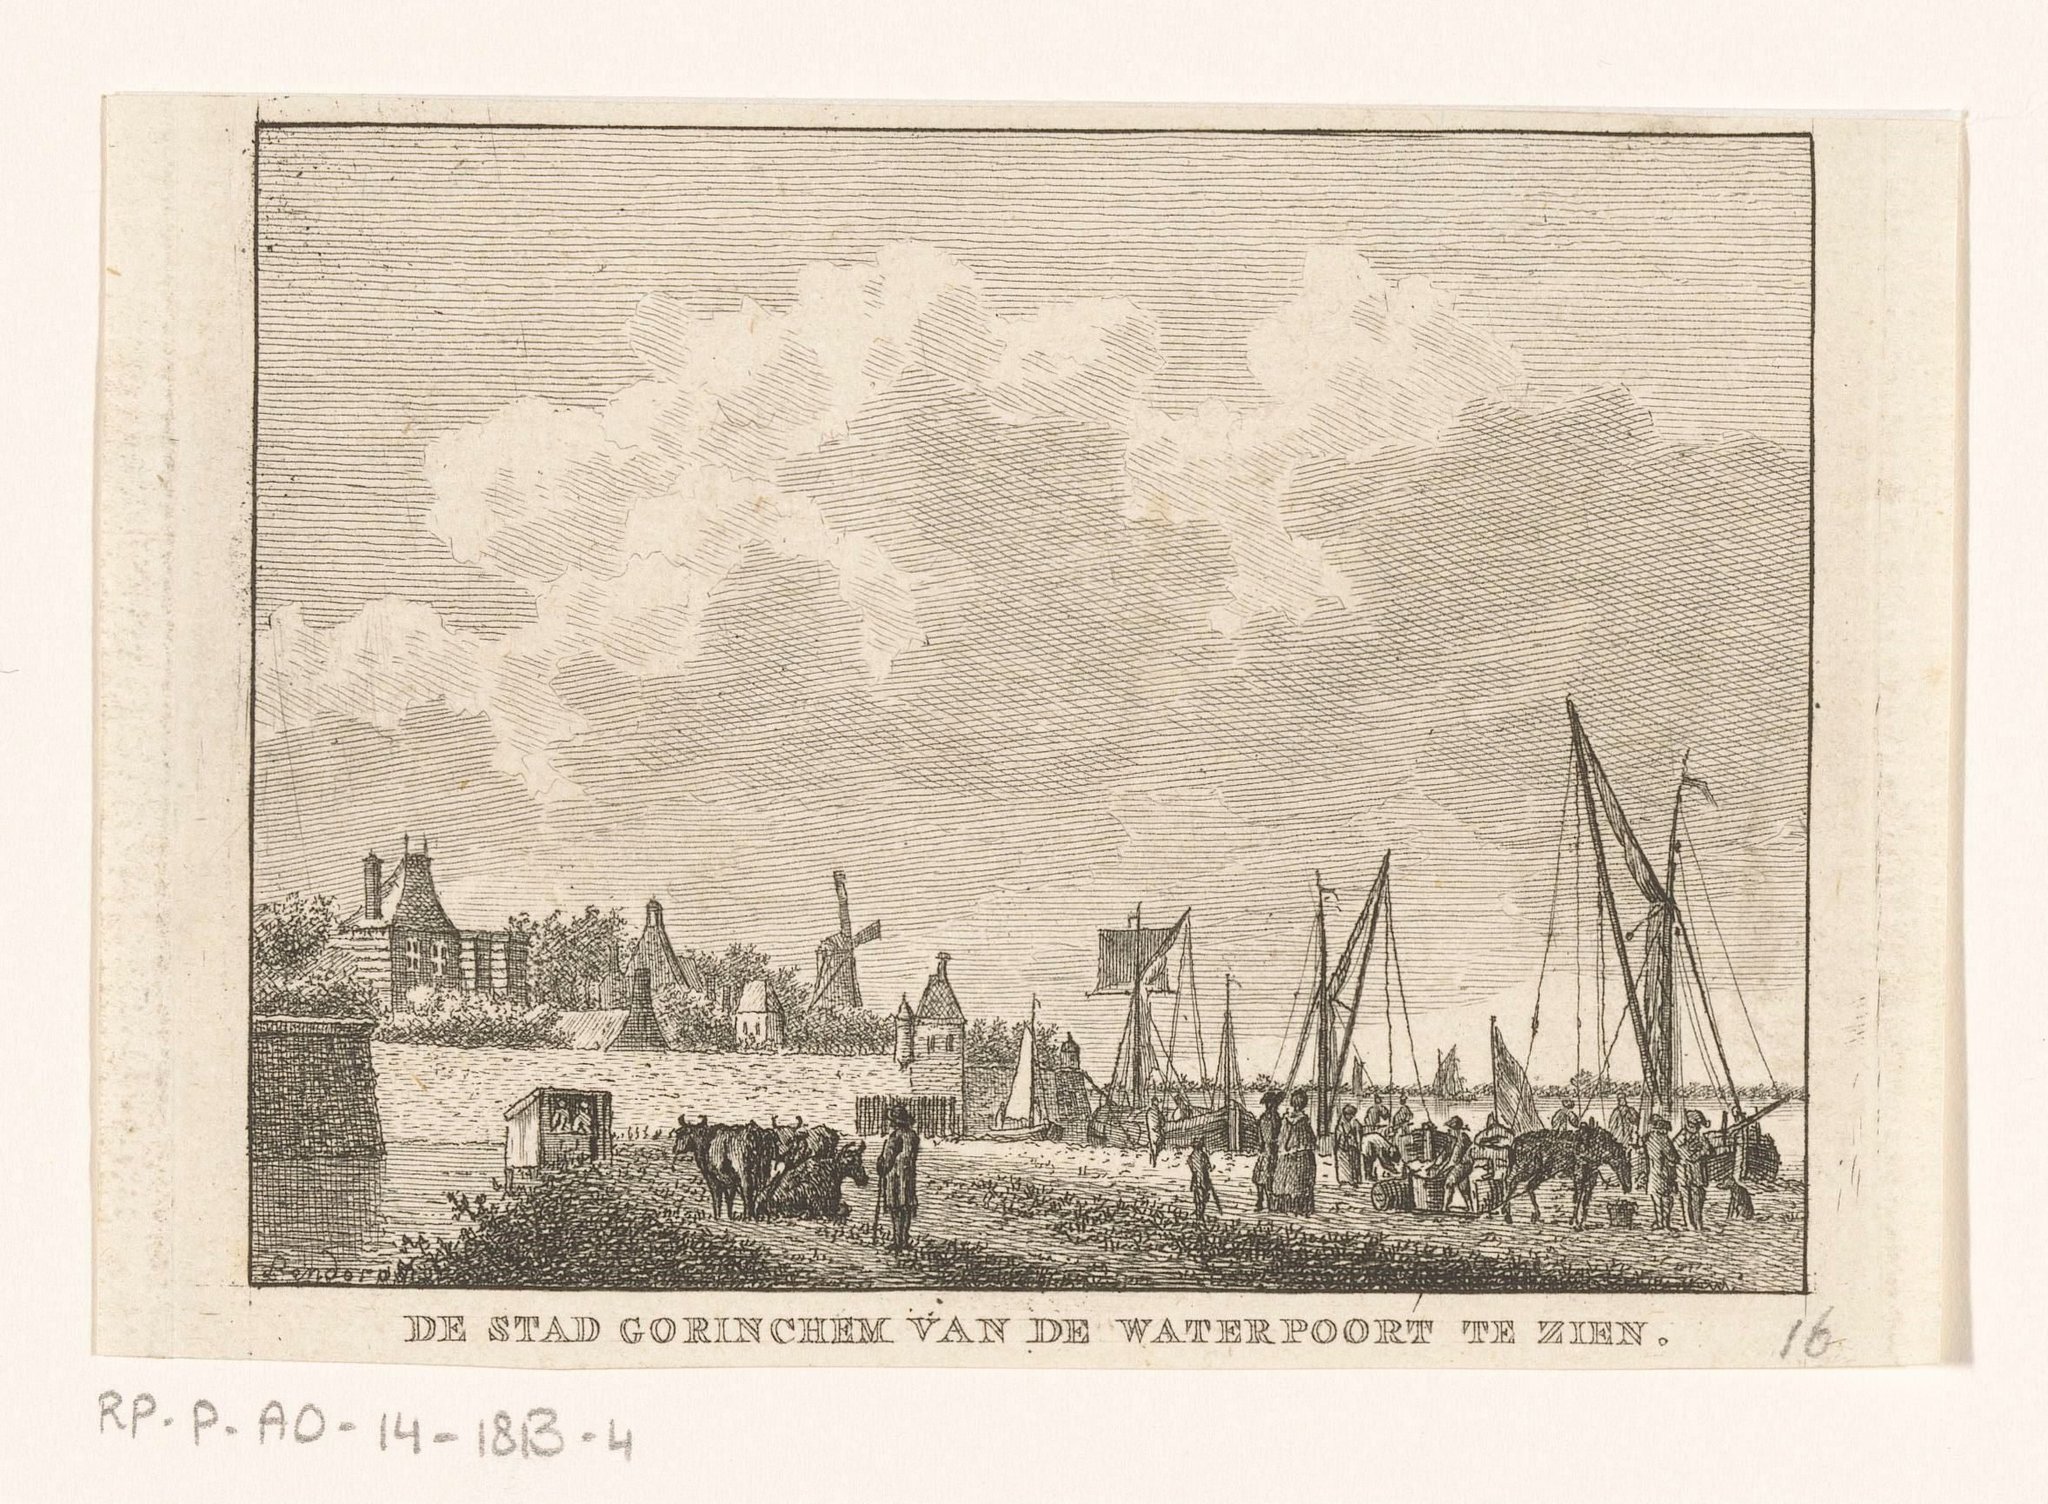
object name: print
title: Gezicht op een deel van de vestingwal van Gorinchem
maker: carel frederik bendorp (i)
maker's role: print maker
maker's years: 1736-1814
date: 1786-1792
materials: paper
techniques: engraving, etching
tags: sailing-ship, sailing-boat, city-walls, windmill, city-gate, prospect of city, town panorama, silhouette of city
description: Prent uit: Vaderlandsche gezichten, of afbeeldingen van den tegenwoordigen staat der Vereenigde Nederlanden (…). Amsterdam: Hendrik Gartman, Willem Vermandel en Jan Willem Smit, 1786-1792. Uitgegeven in afleveringen met ieder een eigen bifolium en inhoudsopgave. Alle prenten in deze publicatie zijn gegraveerd door Carel Frederik Bendorp (I) en, in de meeste gevallen, gebaseerd op tekeningen van Jan Bulthuis.